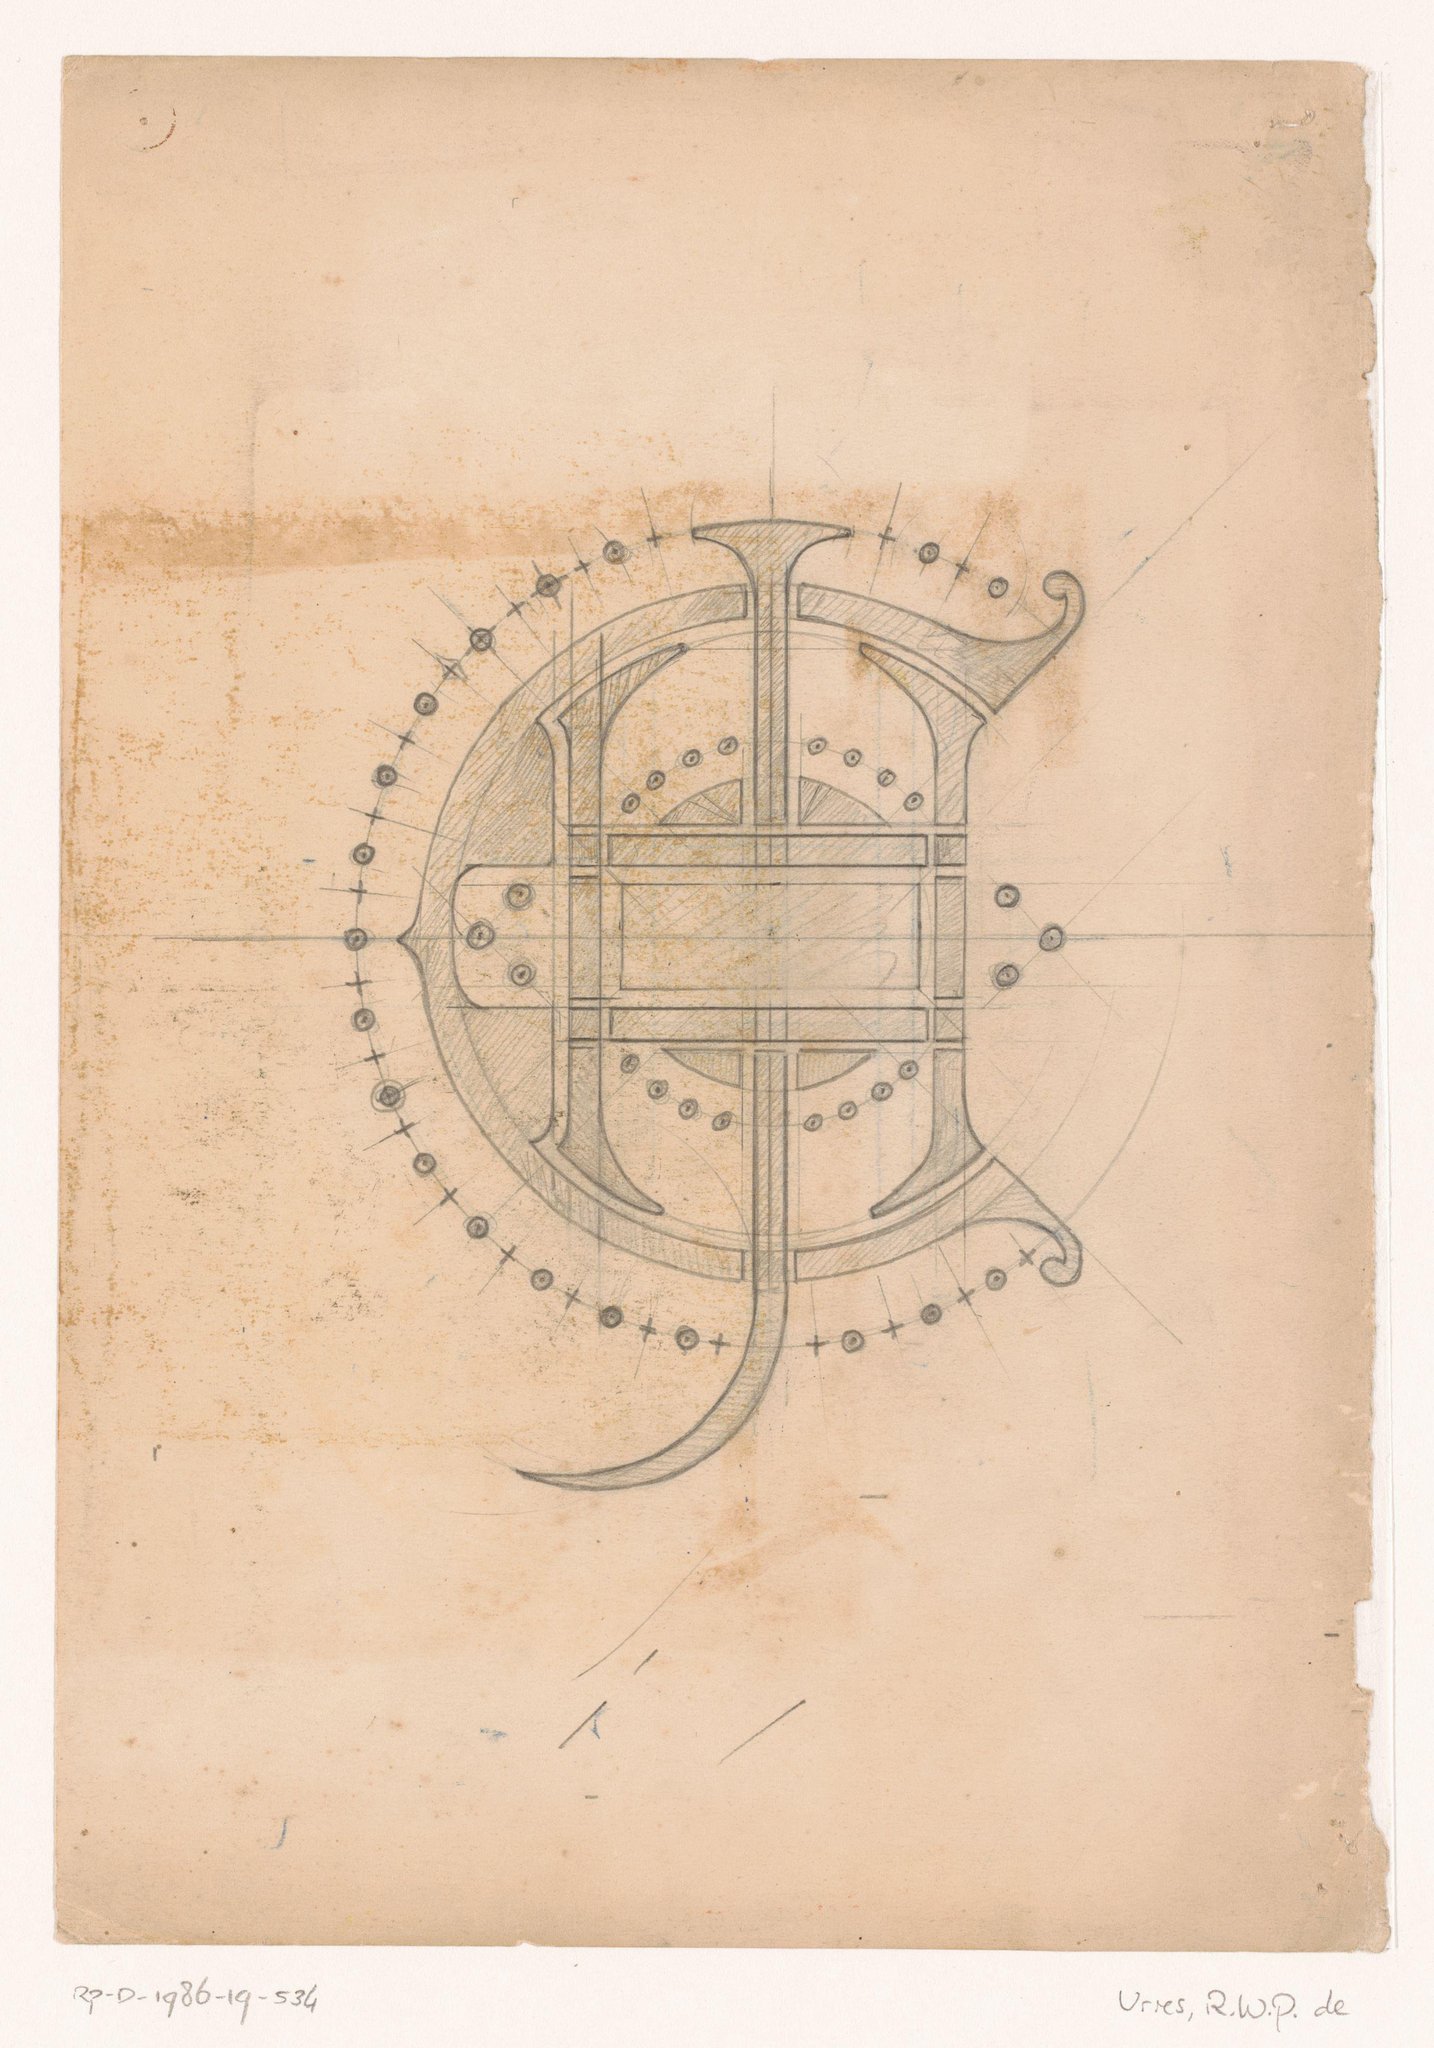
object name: drawing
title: Ontwerp voor een sjabloon met monogram CHJ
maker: reinier willem petrus de vries (1874-1953)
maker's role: draughtsman, print maker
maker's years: 1874-1953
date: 1884-1952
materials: paper, pencil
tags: magic mathematical figures; magic numbers, words, monograms